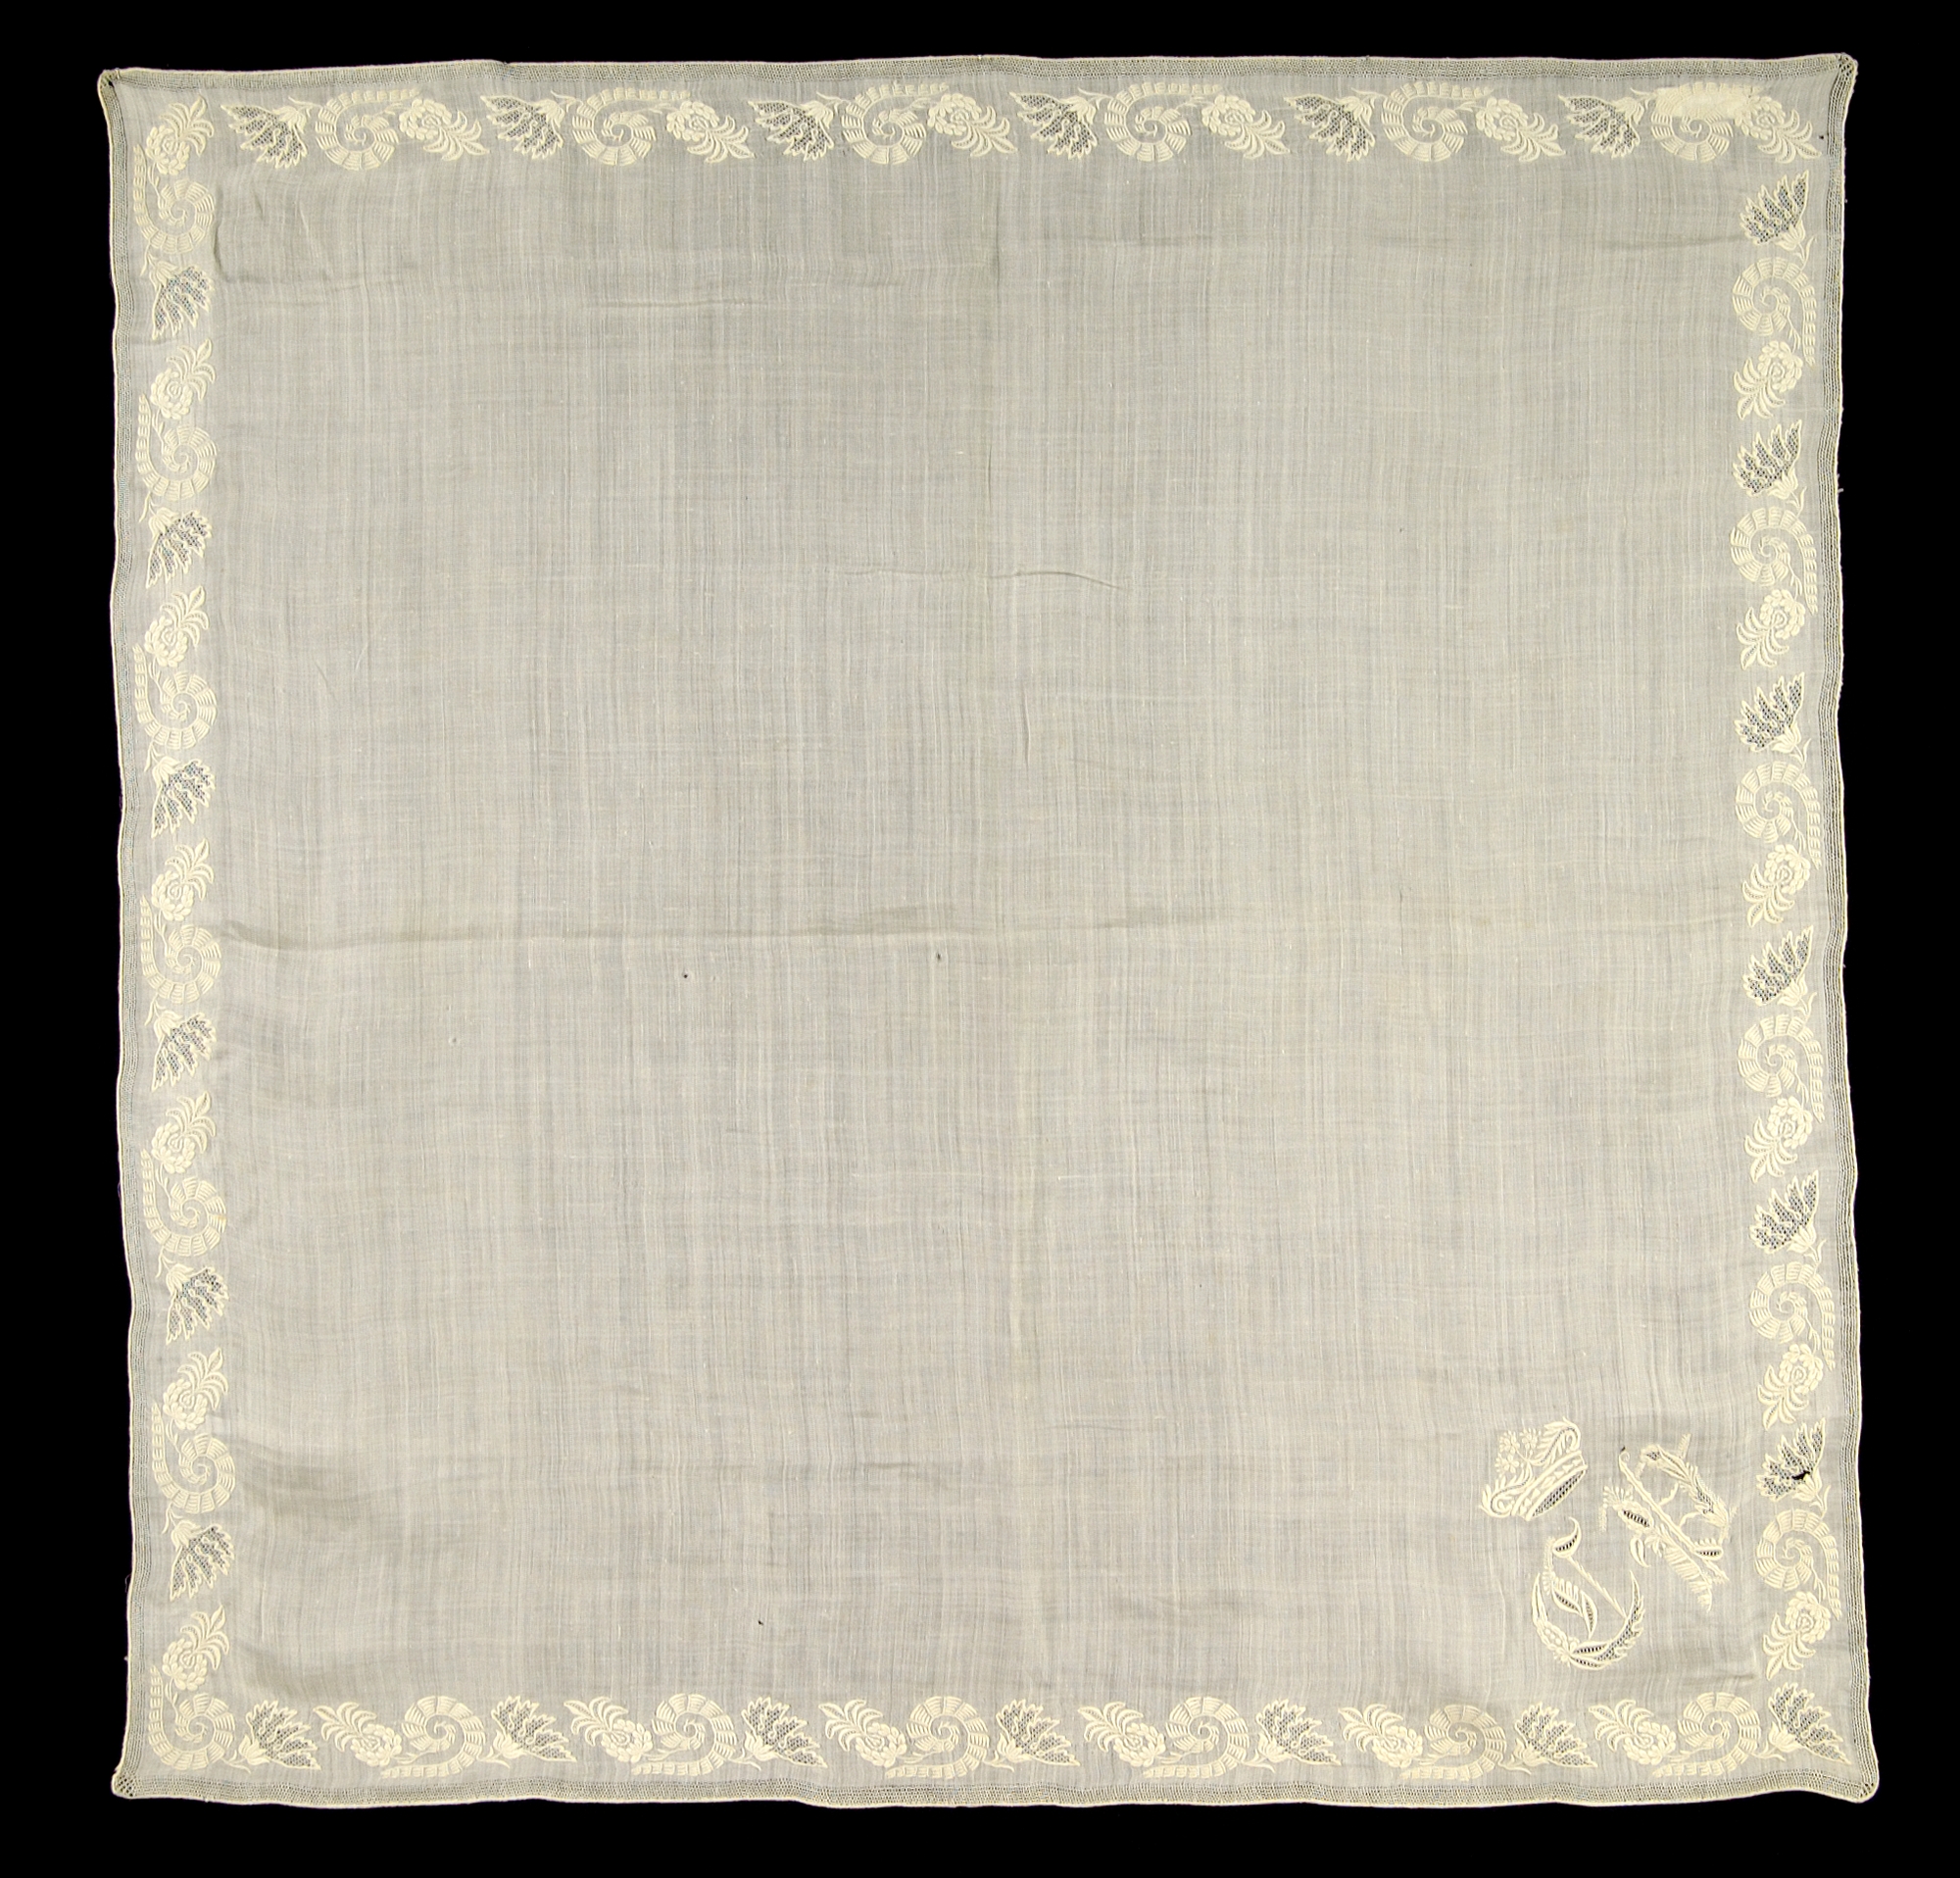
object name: handkerchief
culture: french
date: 1830-1850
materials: linen